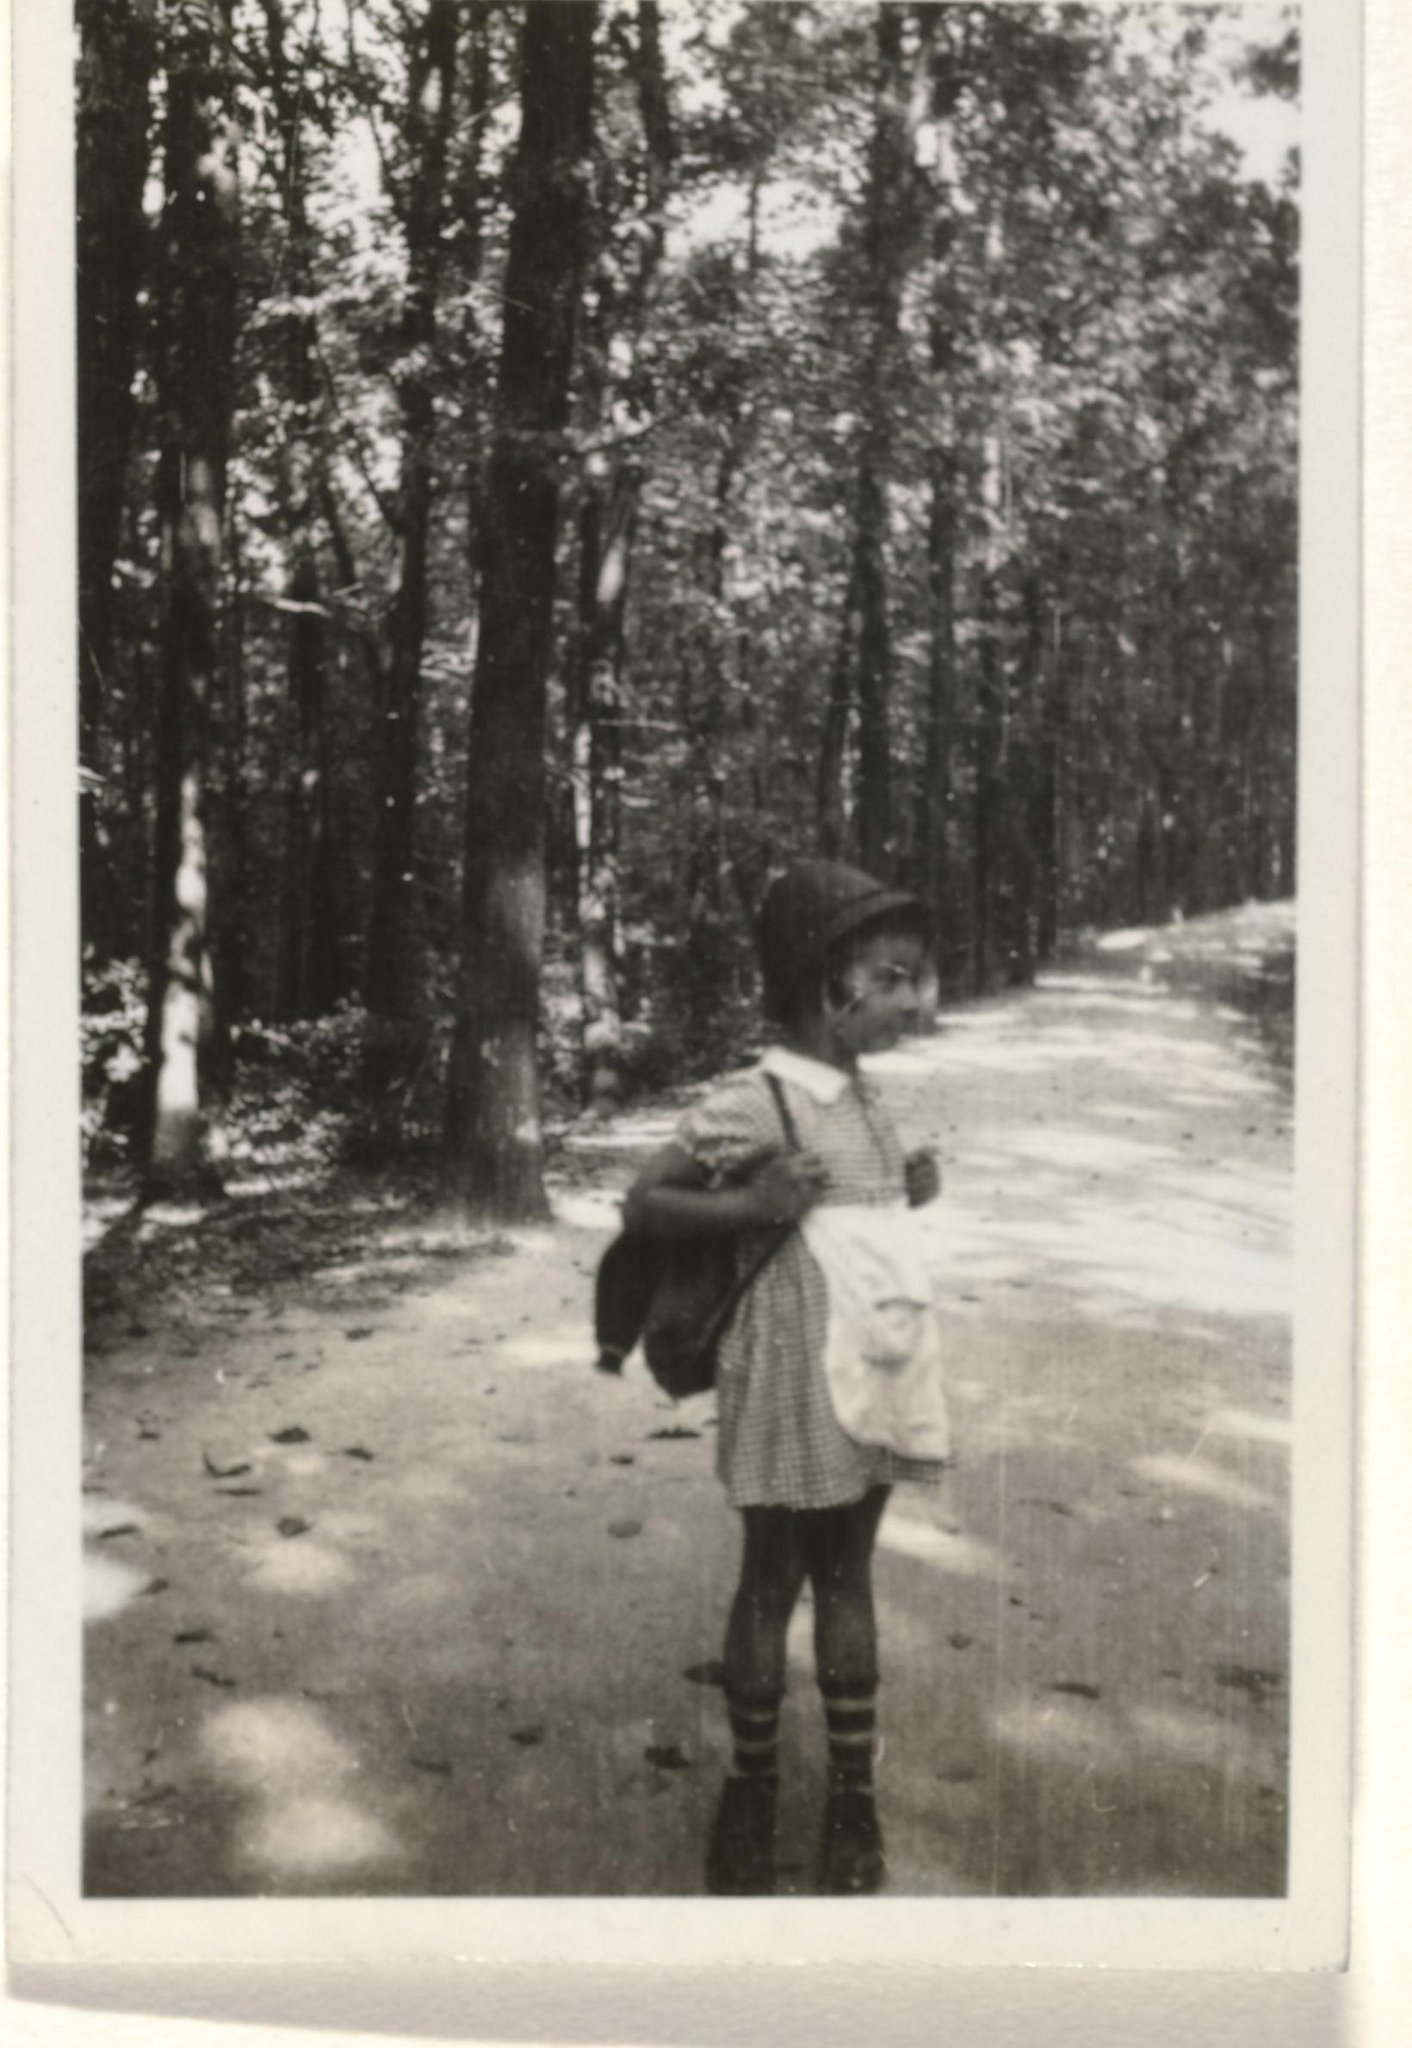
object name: photograph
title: Isabel Wachenheimer op een bergpad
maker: Anonymous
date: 1931-1937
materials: photographic support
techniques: gelatin silver print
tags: isabel wachenheimer-elon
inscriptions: company name: ‘Photo Rieger Rotebühlstr 90 1331’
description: Isabel Wachenheimer met wandeluitrusting op een bergpad.